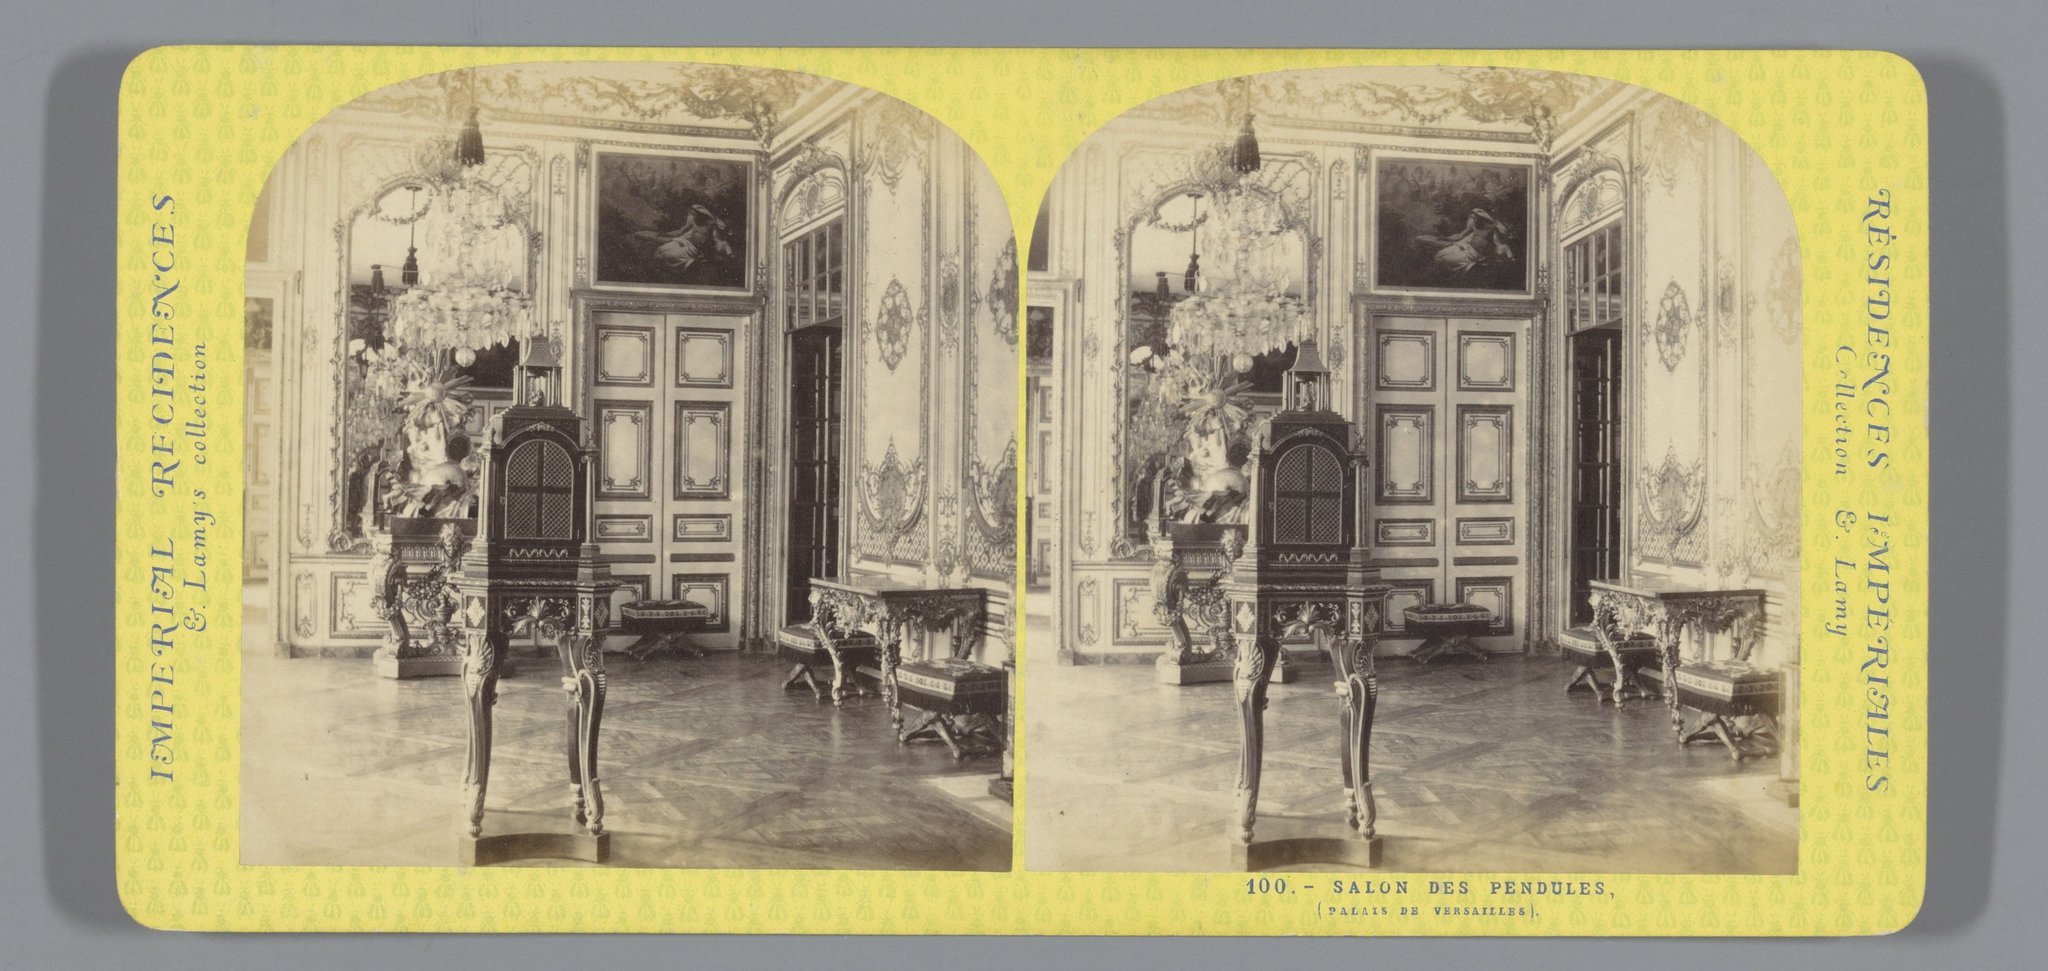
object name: stereograph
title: Salon des Pendules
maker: ernest eléonor pierre lamy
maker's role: publisher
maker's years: 1828-1900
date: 1860-1880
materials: cardboard, photographic support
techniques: albumen print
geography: versailles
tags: drawing-room, 'salon', interior ~ representation of a building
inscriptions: inscription: ‘E. Lamy's collection’, number: ‘100.’